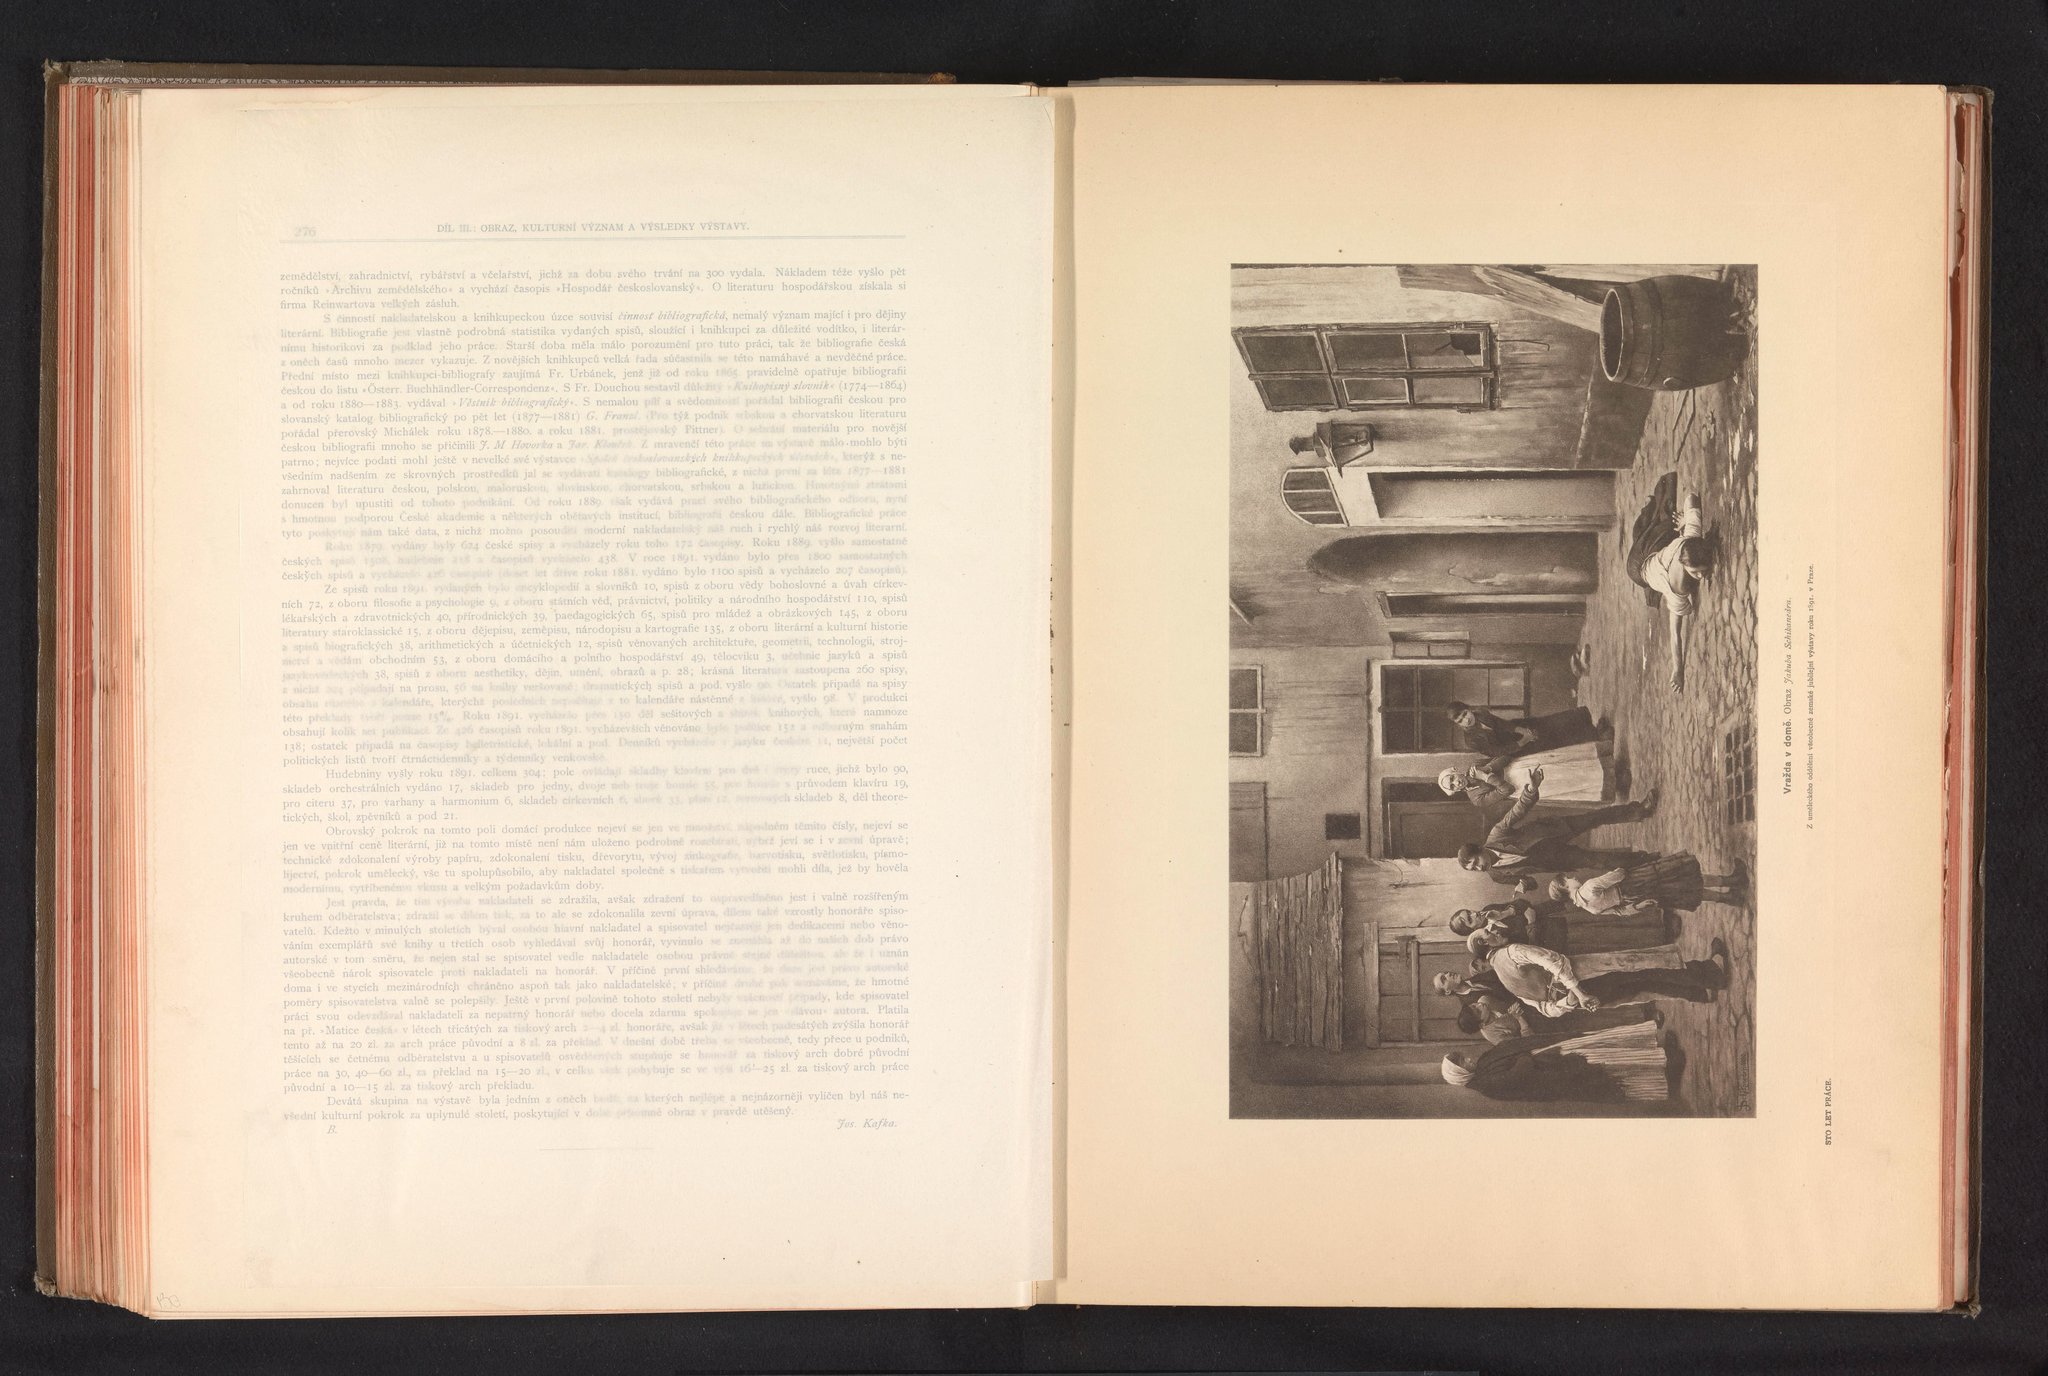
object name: page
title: Fotoreproductie van een schilderij, voorstellende dorpelingen vinden het lijk van een vermoorde vrouw op straat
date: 1890-1895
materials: paper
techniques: photograph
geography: prague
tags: finding a dead person, the corpse, street